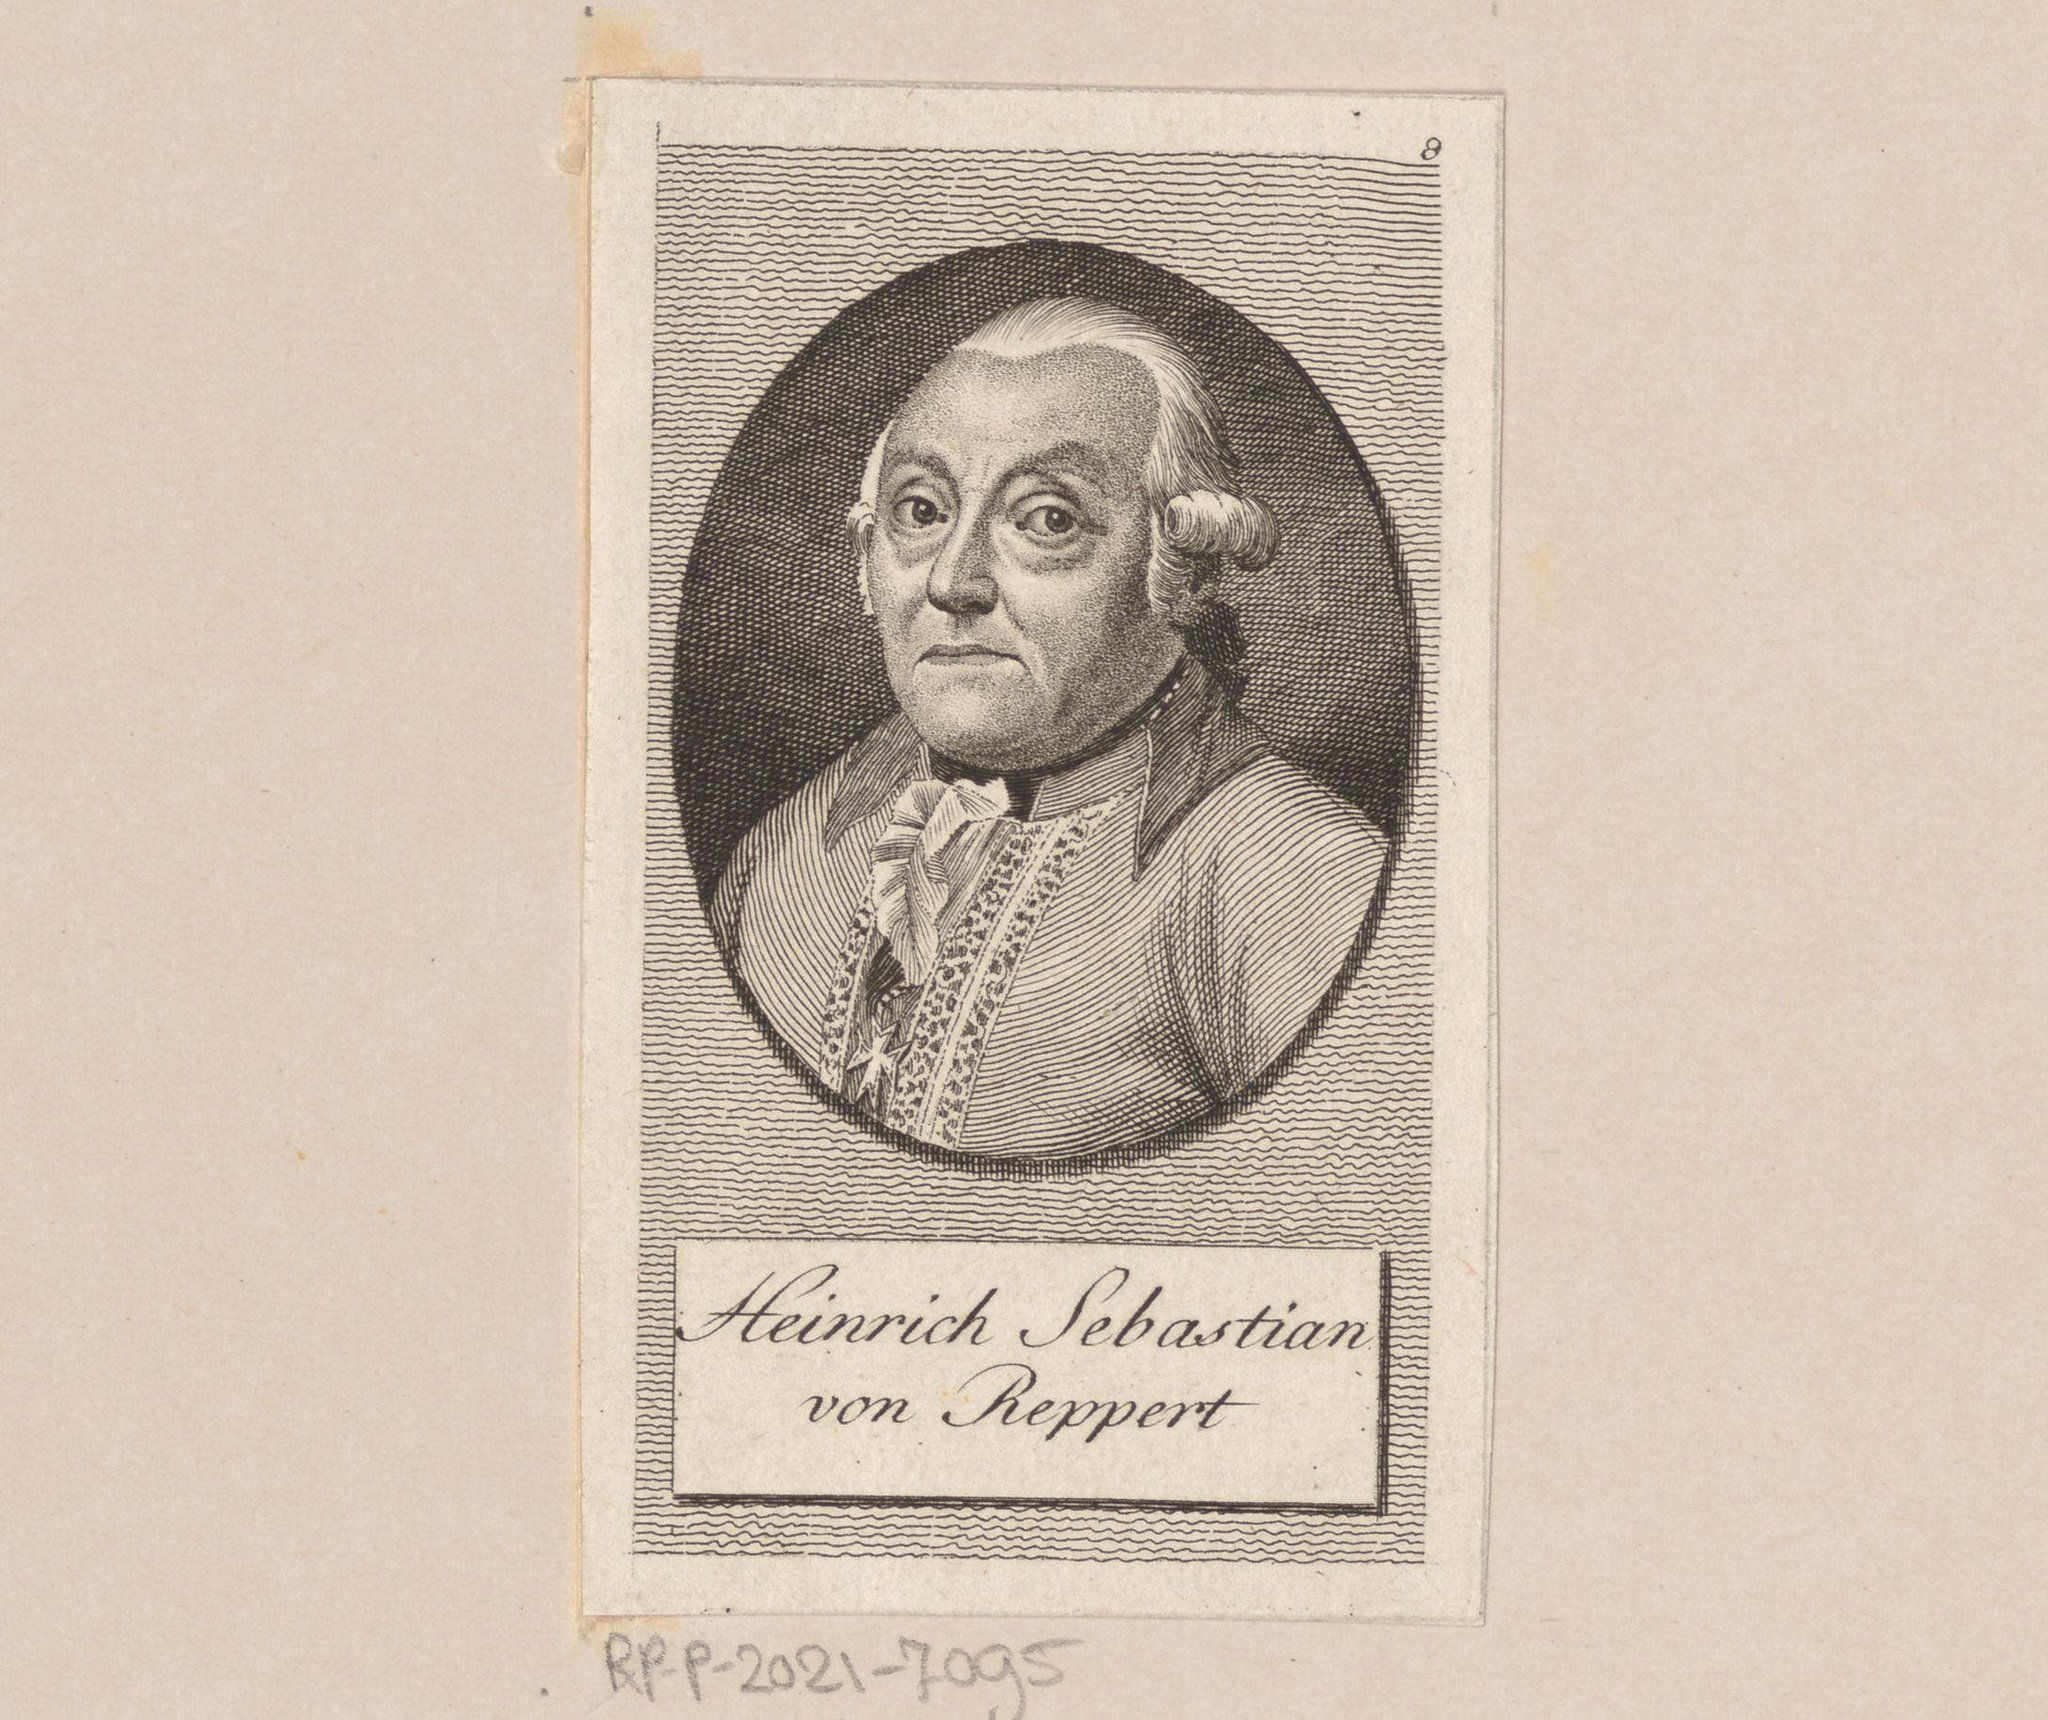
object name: print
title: Portret van Heinrich Sebastian von Reppert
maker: Anonymous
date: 1738-1849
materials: paper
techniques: engraving, etching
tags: historical persons